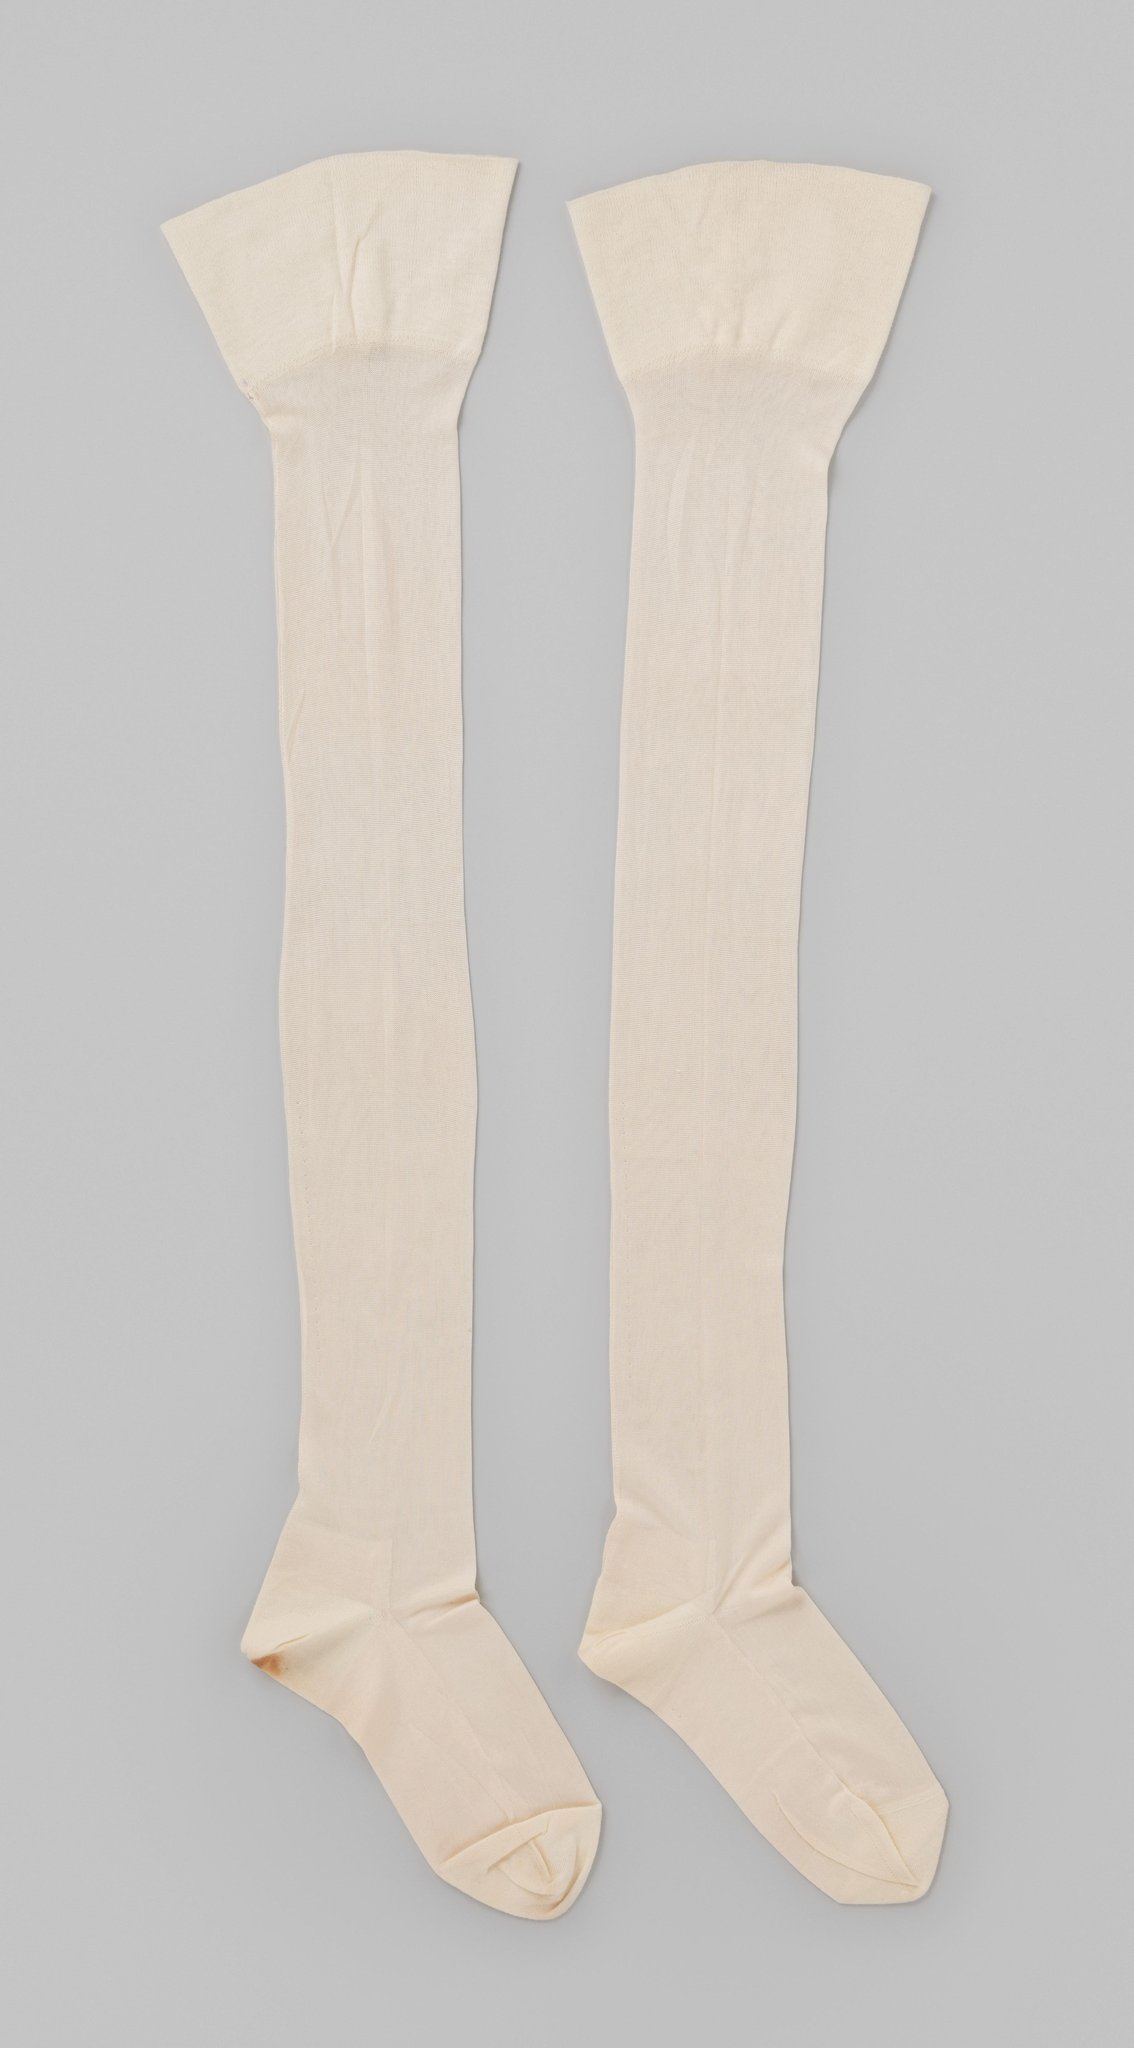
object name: stocking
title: Kous gebreid van effen witte zijde met katoenen boord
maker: Anonymous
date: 1910-1920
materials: cotton, silk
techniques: knitting, printing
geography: lille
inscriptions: inscription: ‘'.... THREAD SILK MERCERIZED'’, size: ‘'8 1/2'’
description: Kous, van een paar, van witte zijde. Model: met naad. Brede boord van katoen. Vierkante hiel. Onder de voet: '.... THREAD SILK MERCERIZED'. Op de teen '8 1/2'.